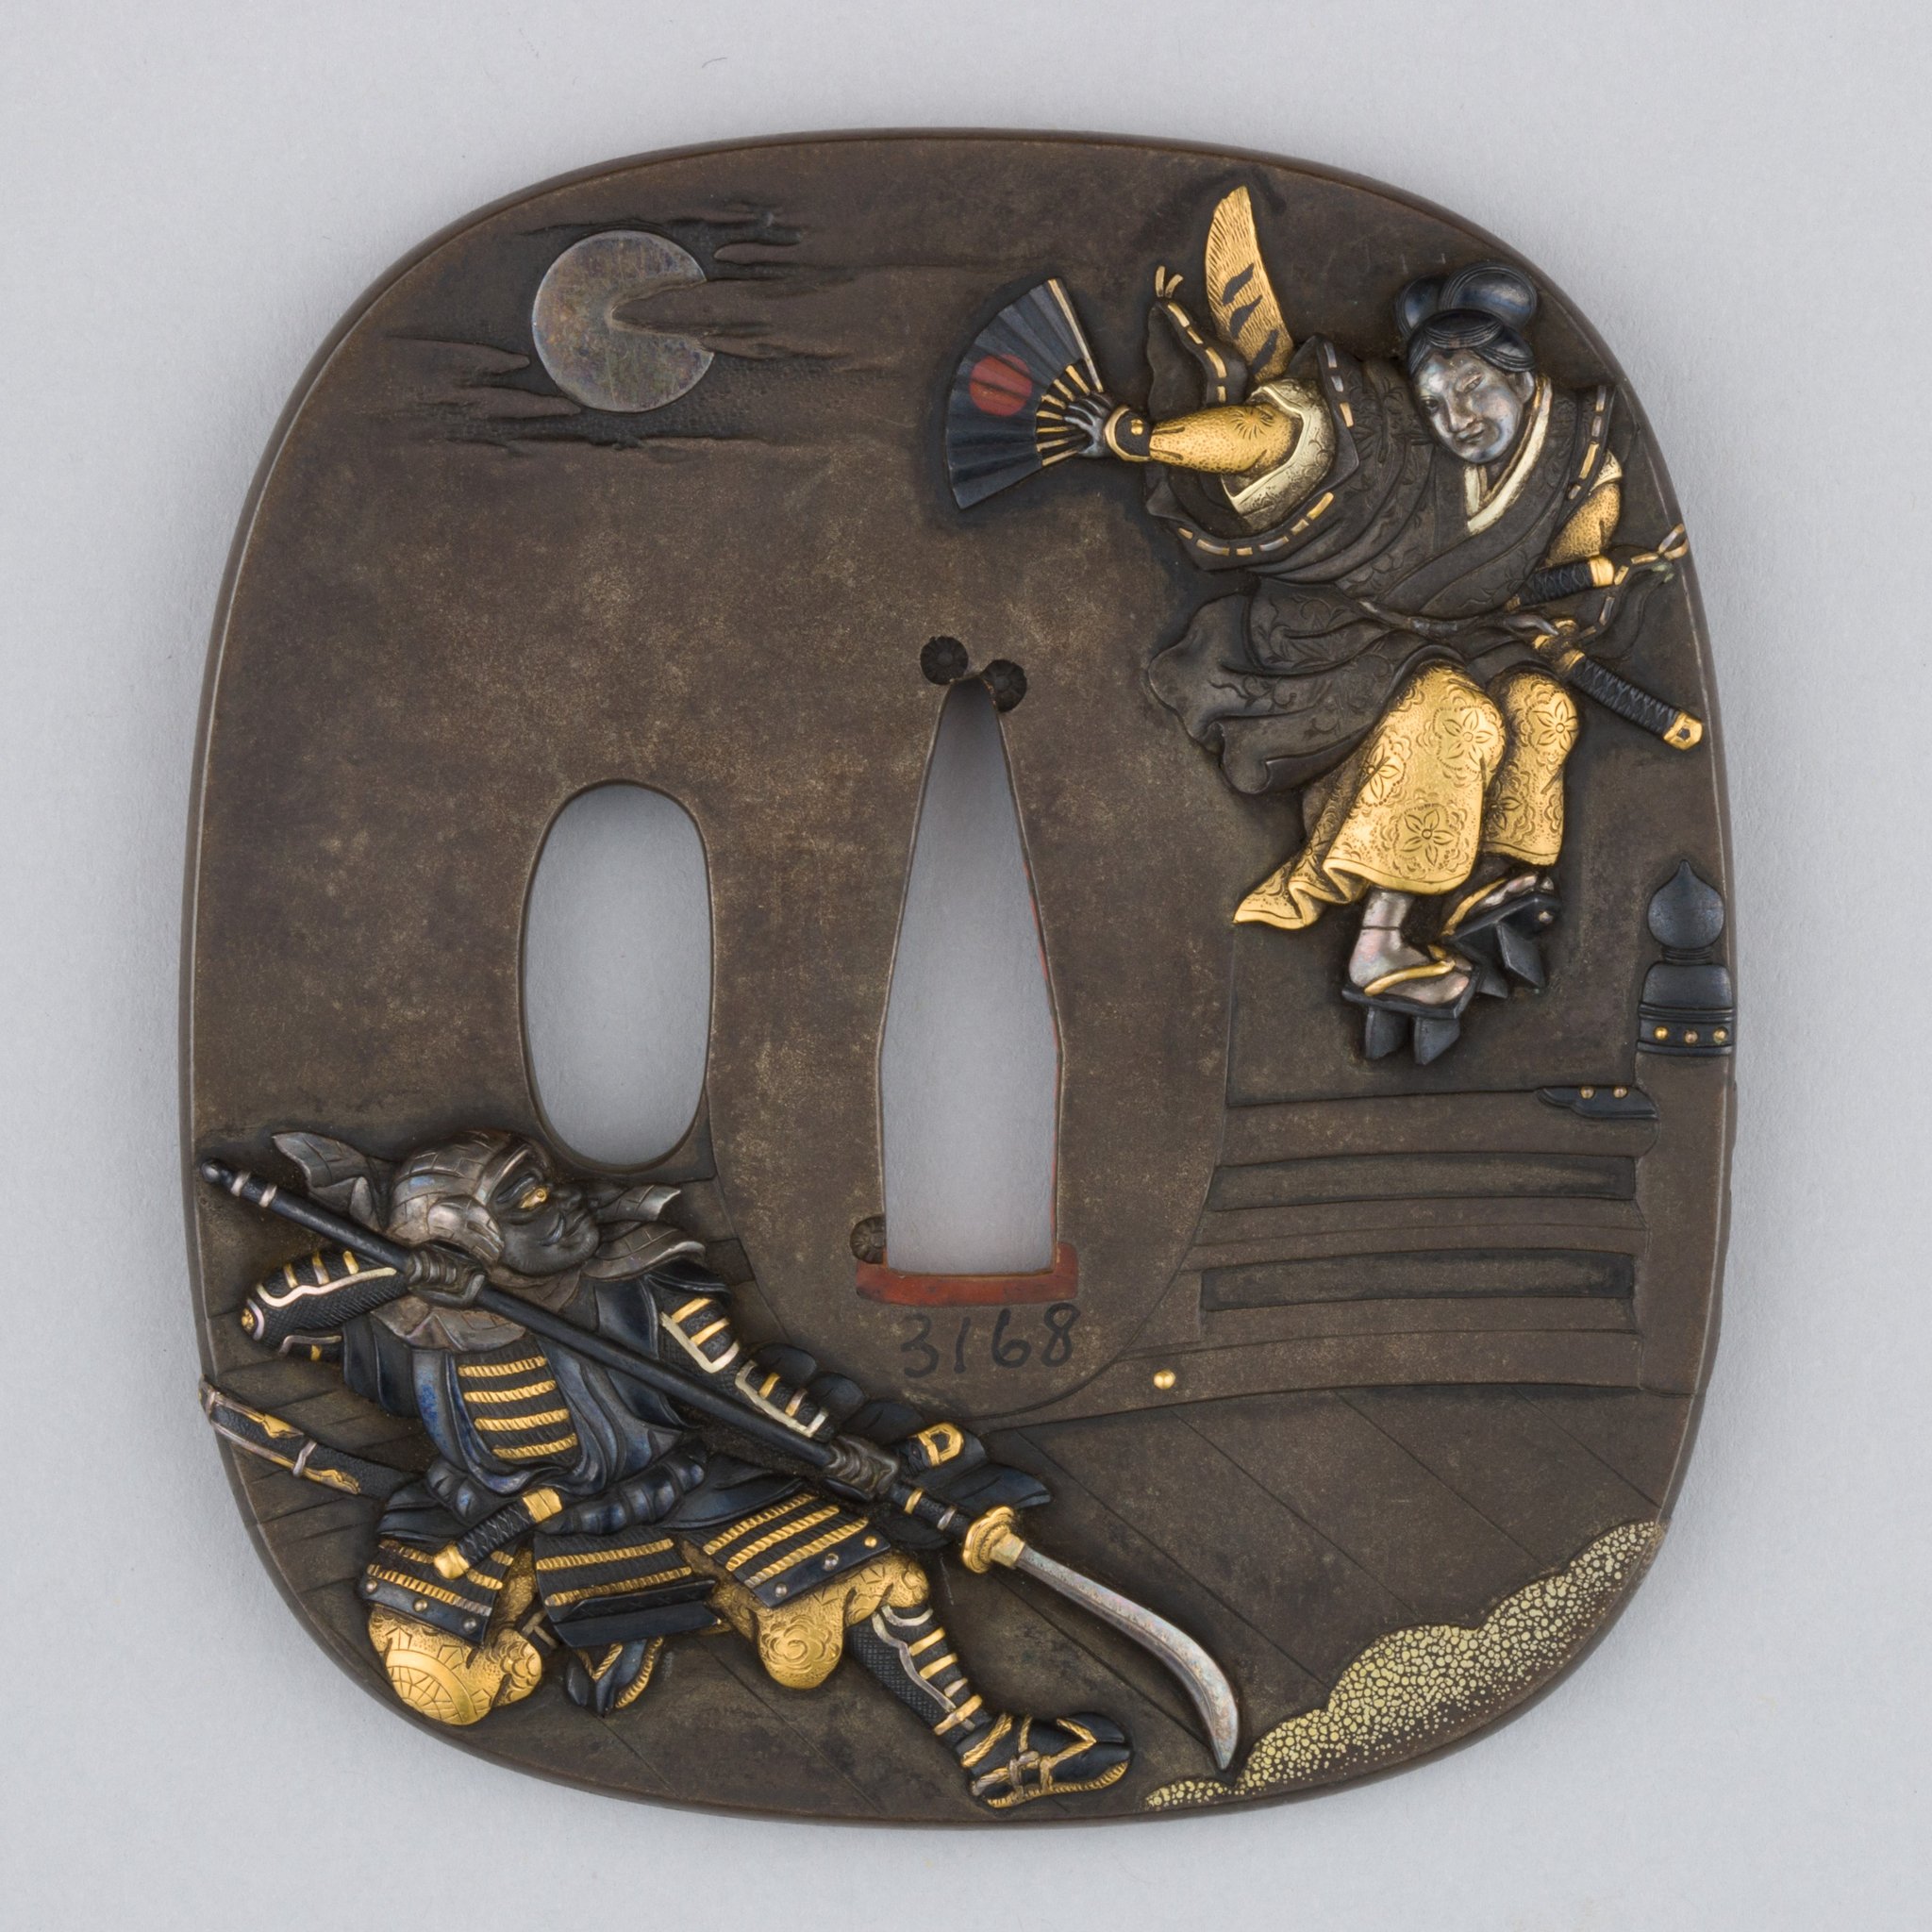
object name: sword guard tsuba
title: Sword Guard (Tsuba)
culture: japanese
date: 1805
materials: copper, gold alloy, silver alloy, gold, silver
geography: japan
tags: fans,swords,men